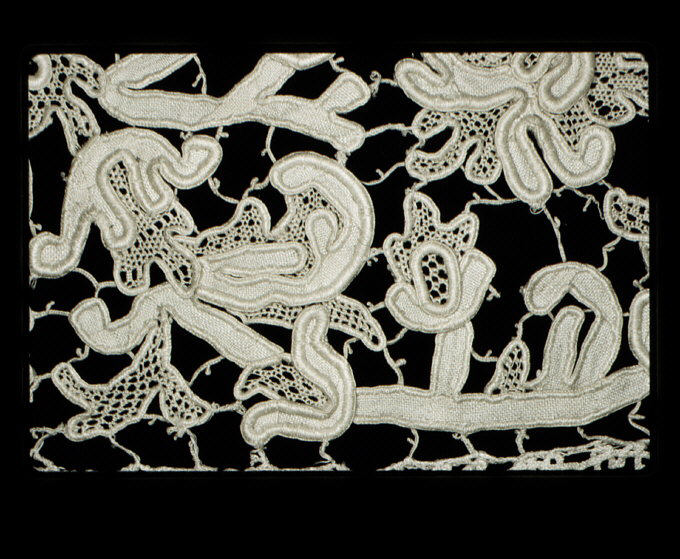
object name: strip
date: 1701-1725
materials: lace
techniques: lace, gros point